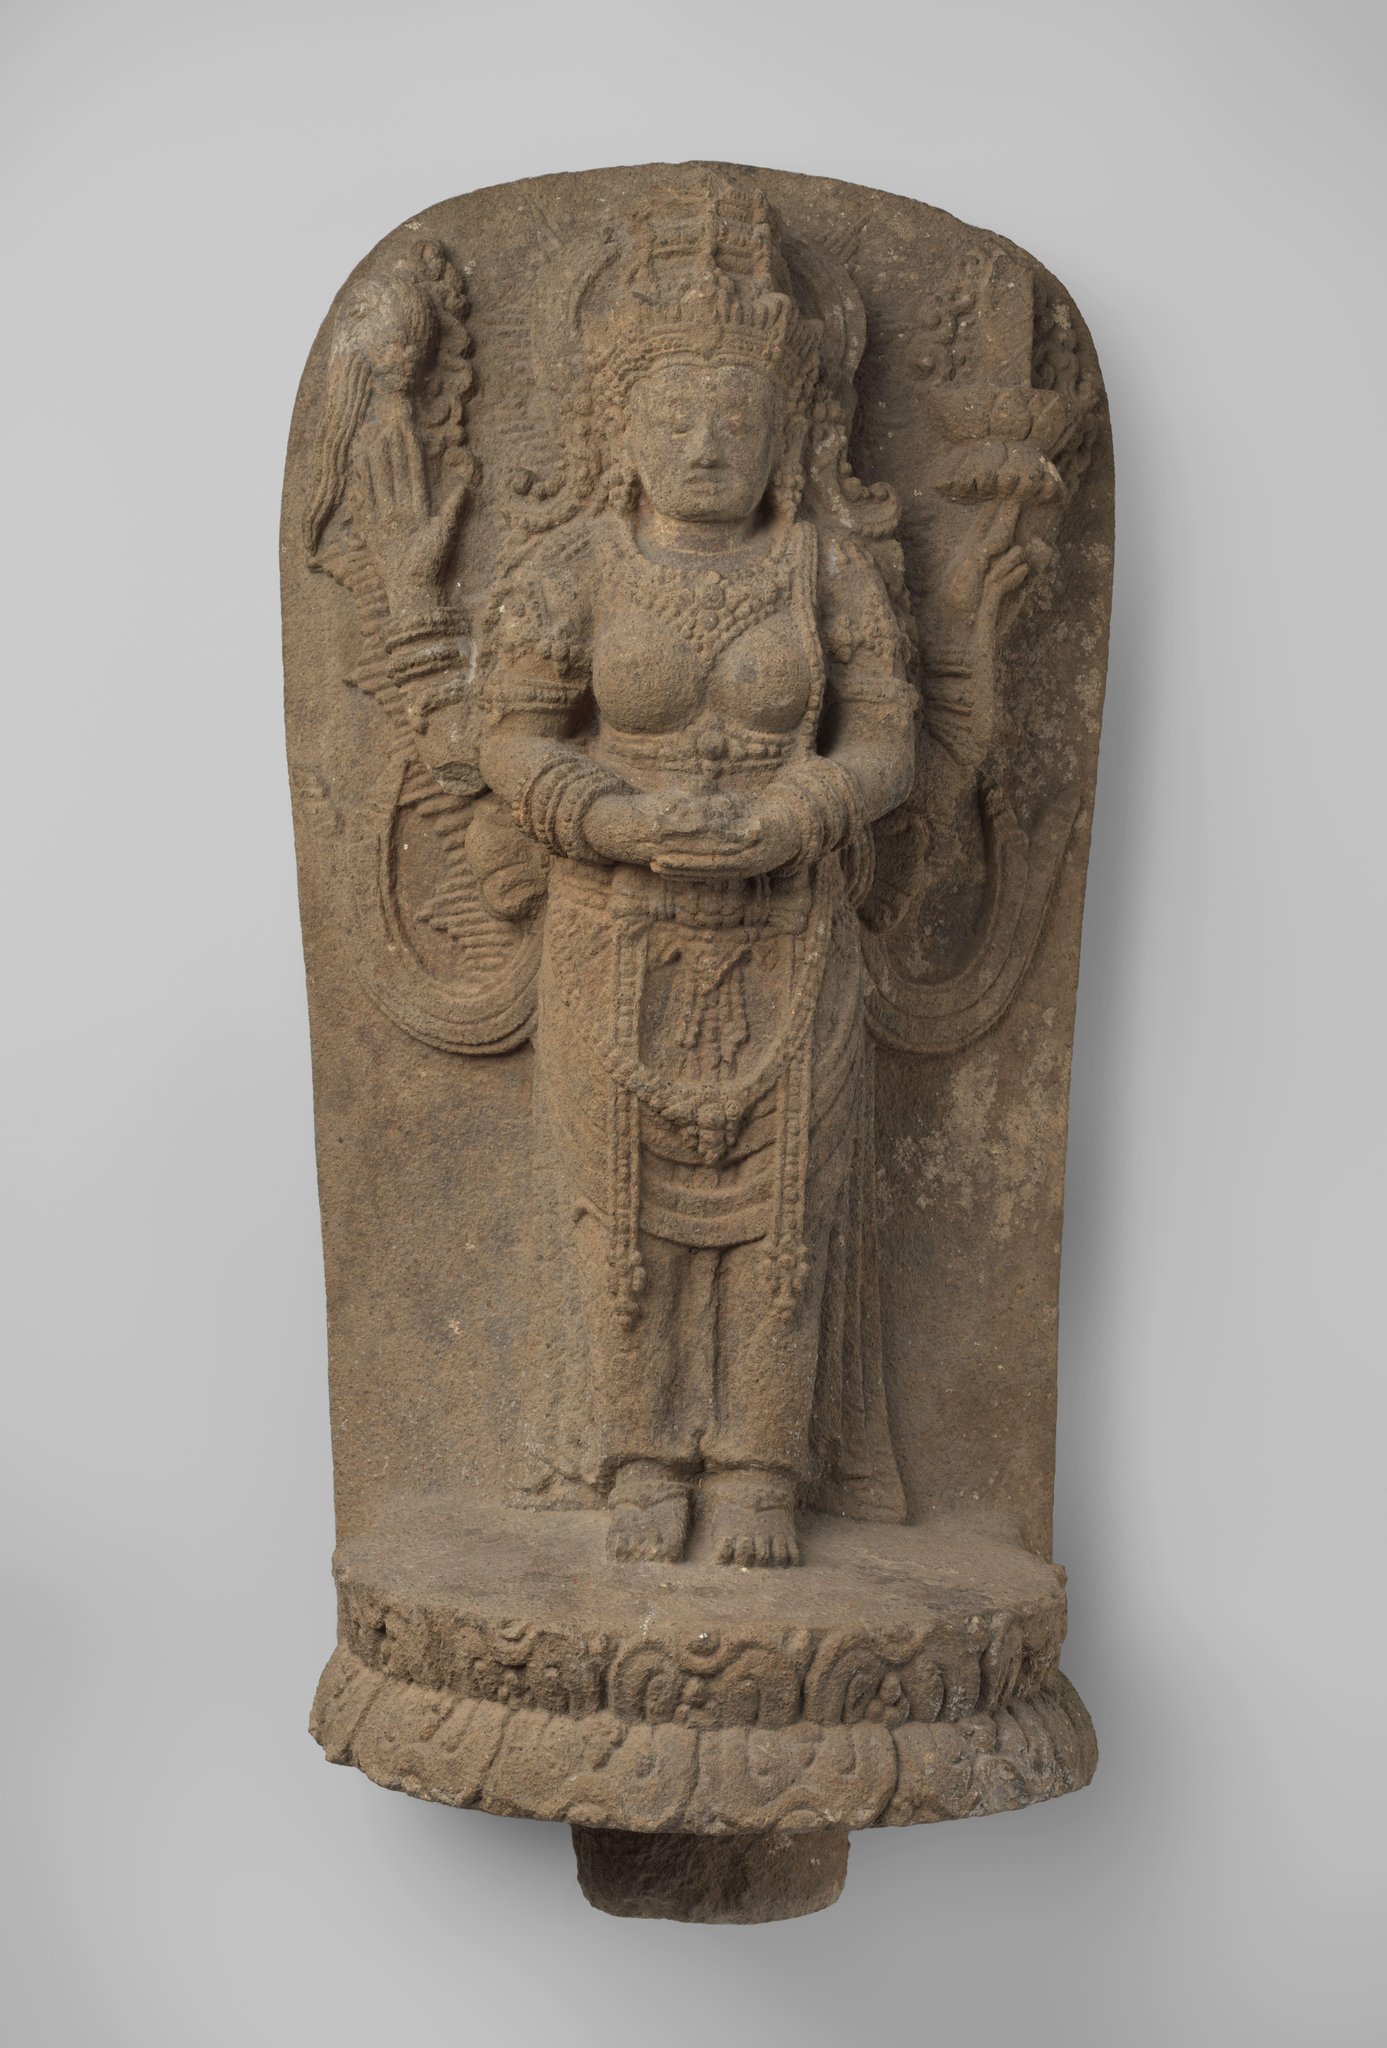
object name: sculpture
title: A deified woman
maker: Anonymous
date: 1300-1399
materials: rock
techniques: carved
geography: east java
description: In the Majapahit kingdom on Java, members of the royal family were often identified with gods from Buddhism or Hinduism after their death. This relief represents the deified form of a queen or princess. She has four arms and is standing in a static, upright pose. She holds a lotus flower, a symbol of divinity, in her two front hands.